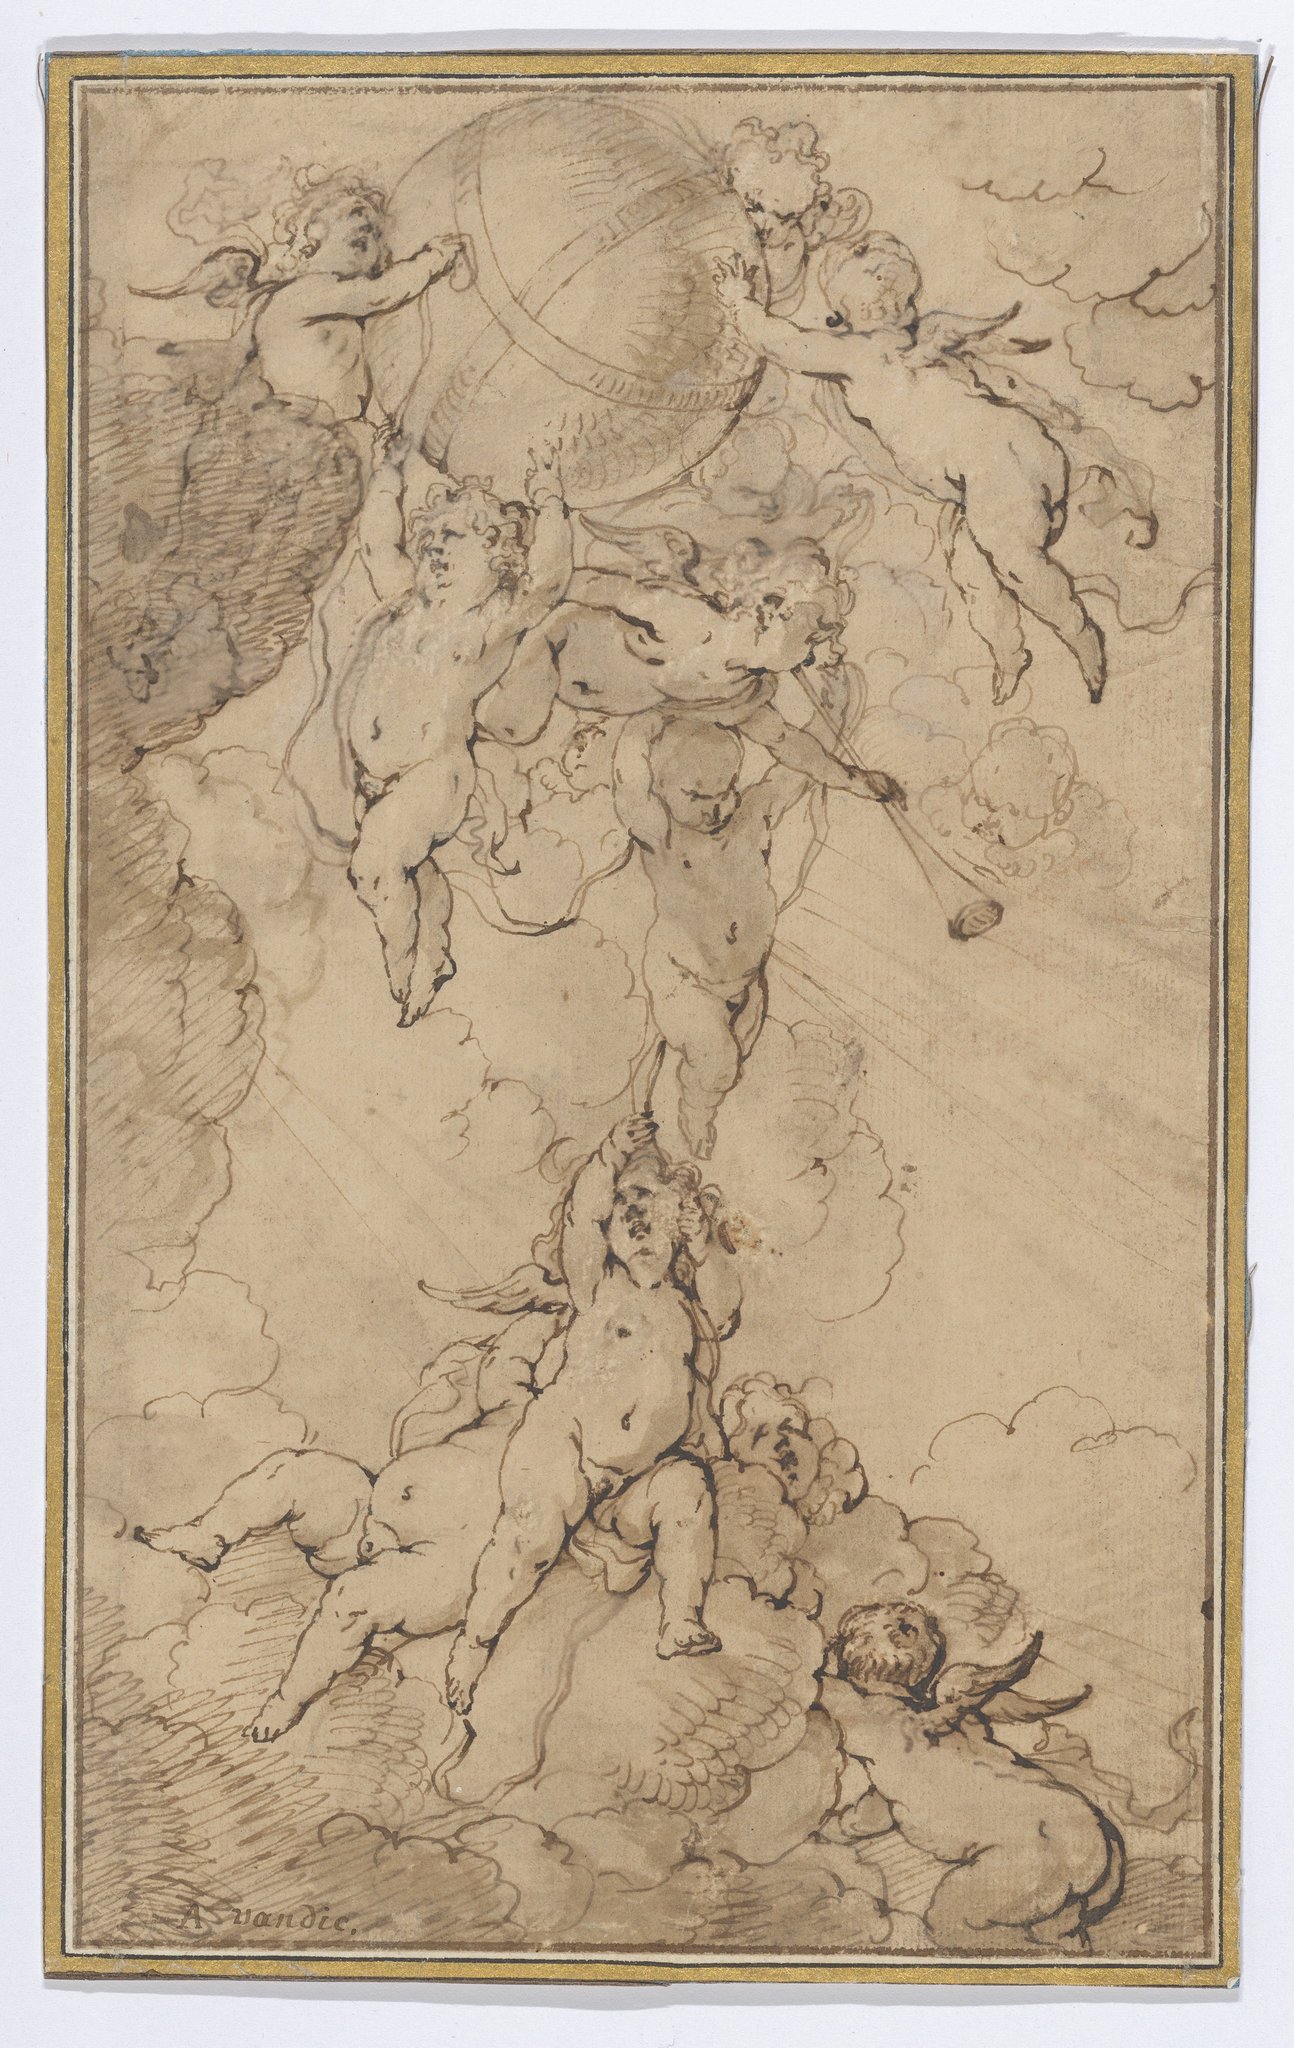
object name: drawing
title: Putti in Clouds, Supporting a Globe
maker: jan thomas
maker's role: print maker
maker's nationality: flemish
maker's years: 1617-1678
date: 1634-1666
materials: ink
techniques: brush, pen, wash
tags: globes